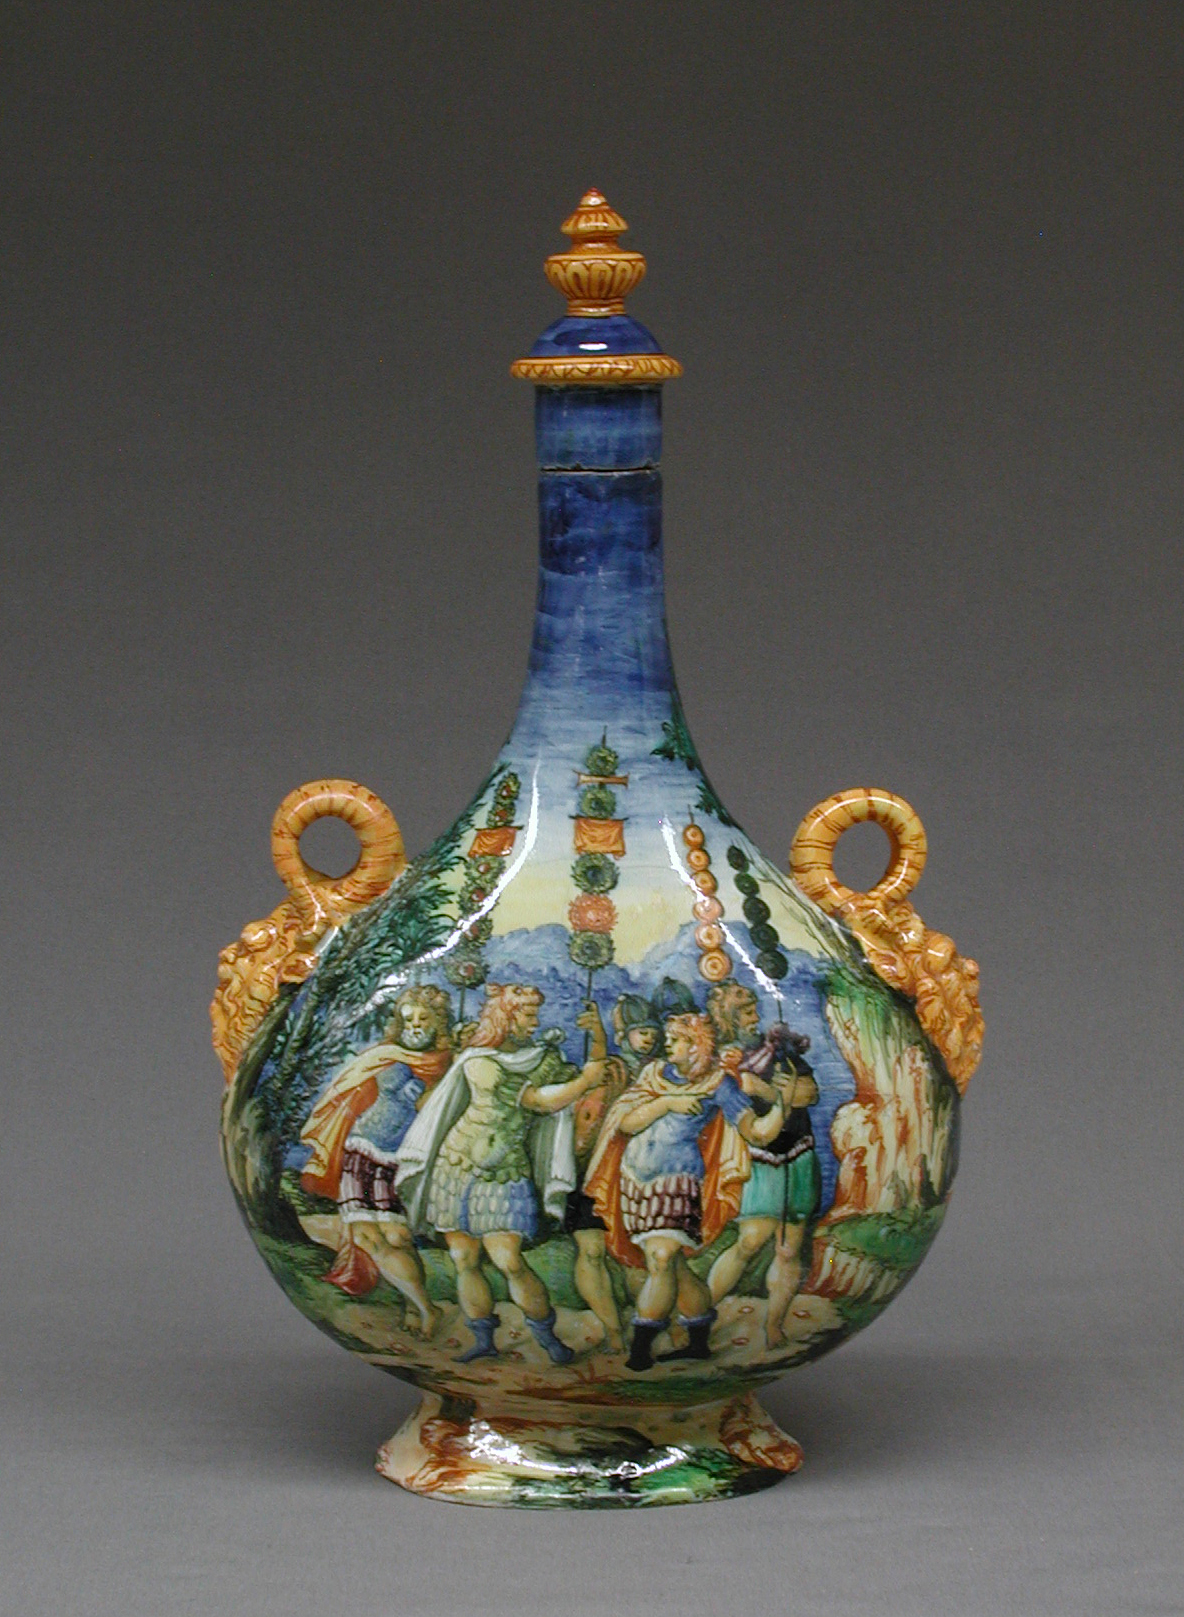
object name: pilgrim bottle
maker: orazio fontana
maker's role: maker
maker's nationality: italian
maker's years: 1505-1576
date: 1550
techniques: maiolica, glazing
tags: men